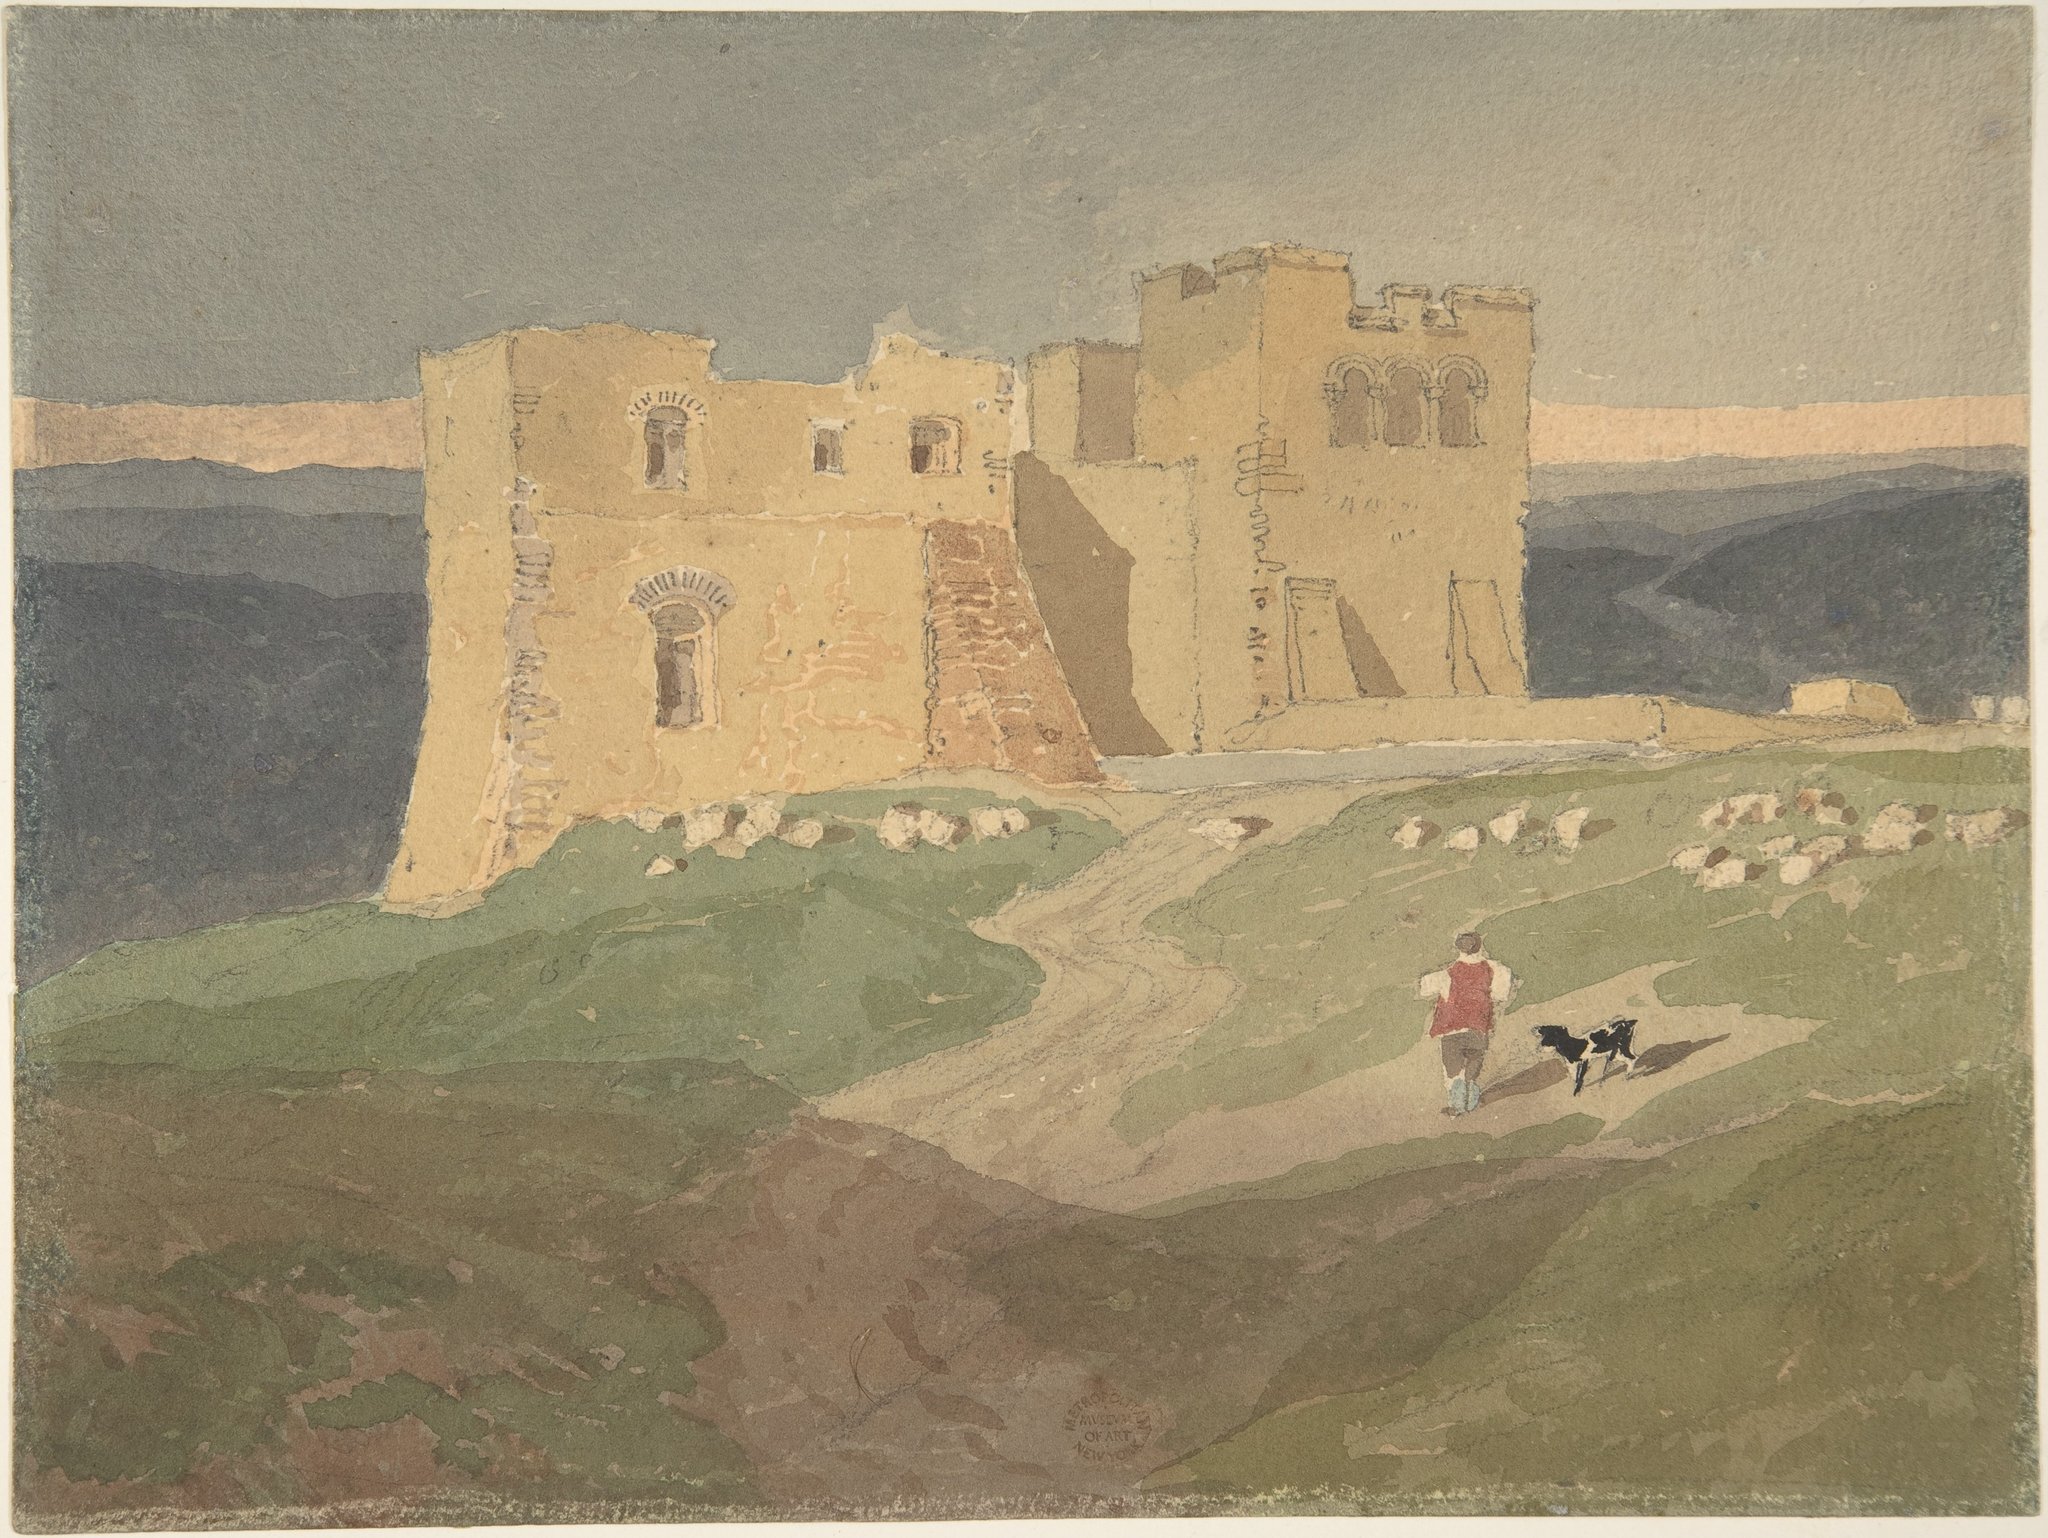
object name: drawing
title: Ruined Castle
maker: john sell cotman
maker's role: artist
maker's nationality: british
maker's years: 1782-1842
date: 1823-1842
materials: graphite, watercolor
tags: human figures,animals,castles,ruins